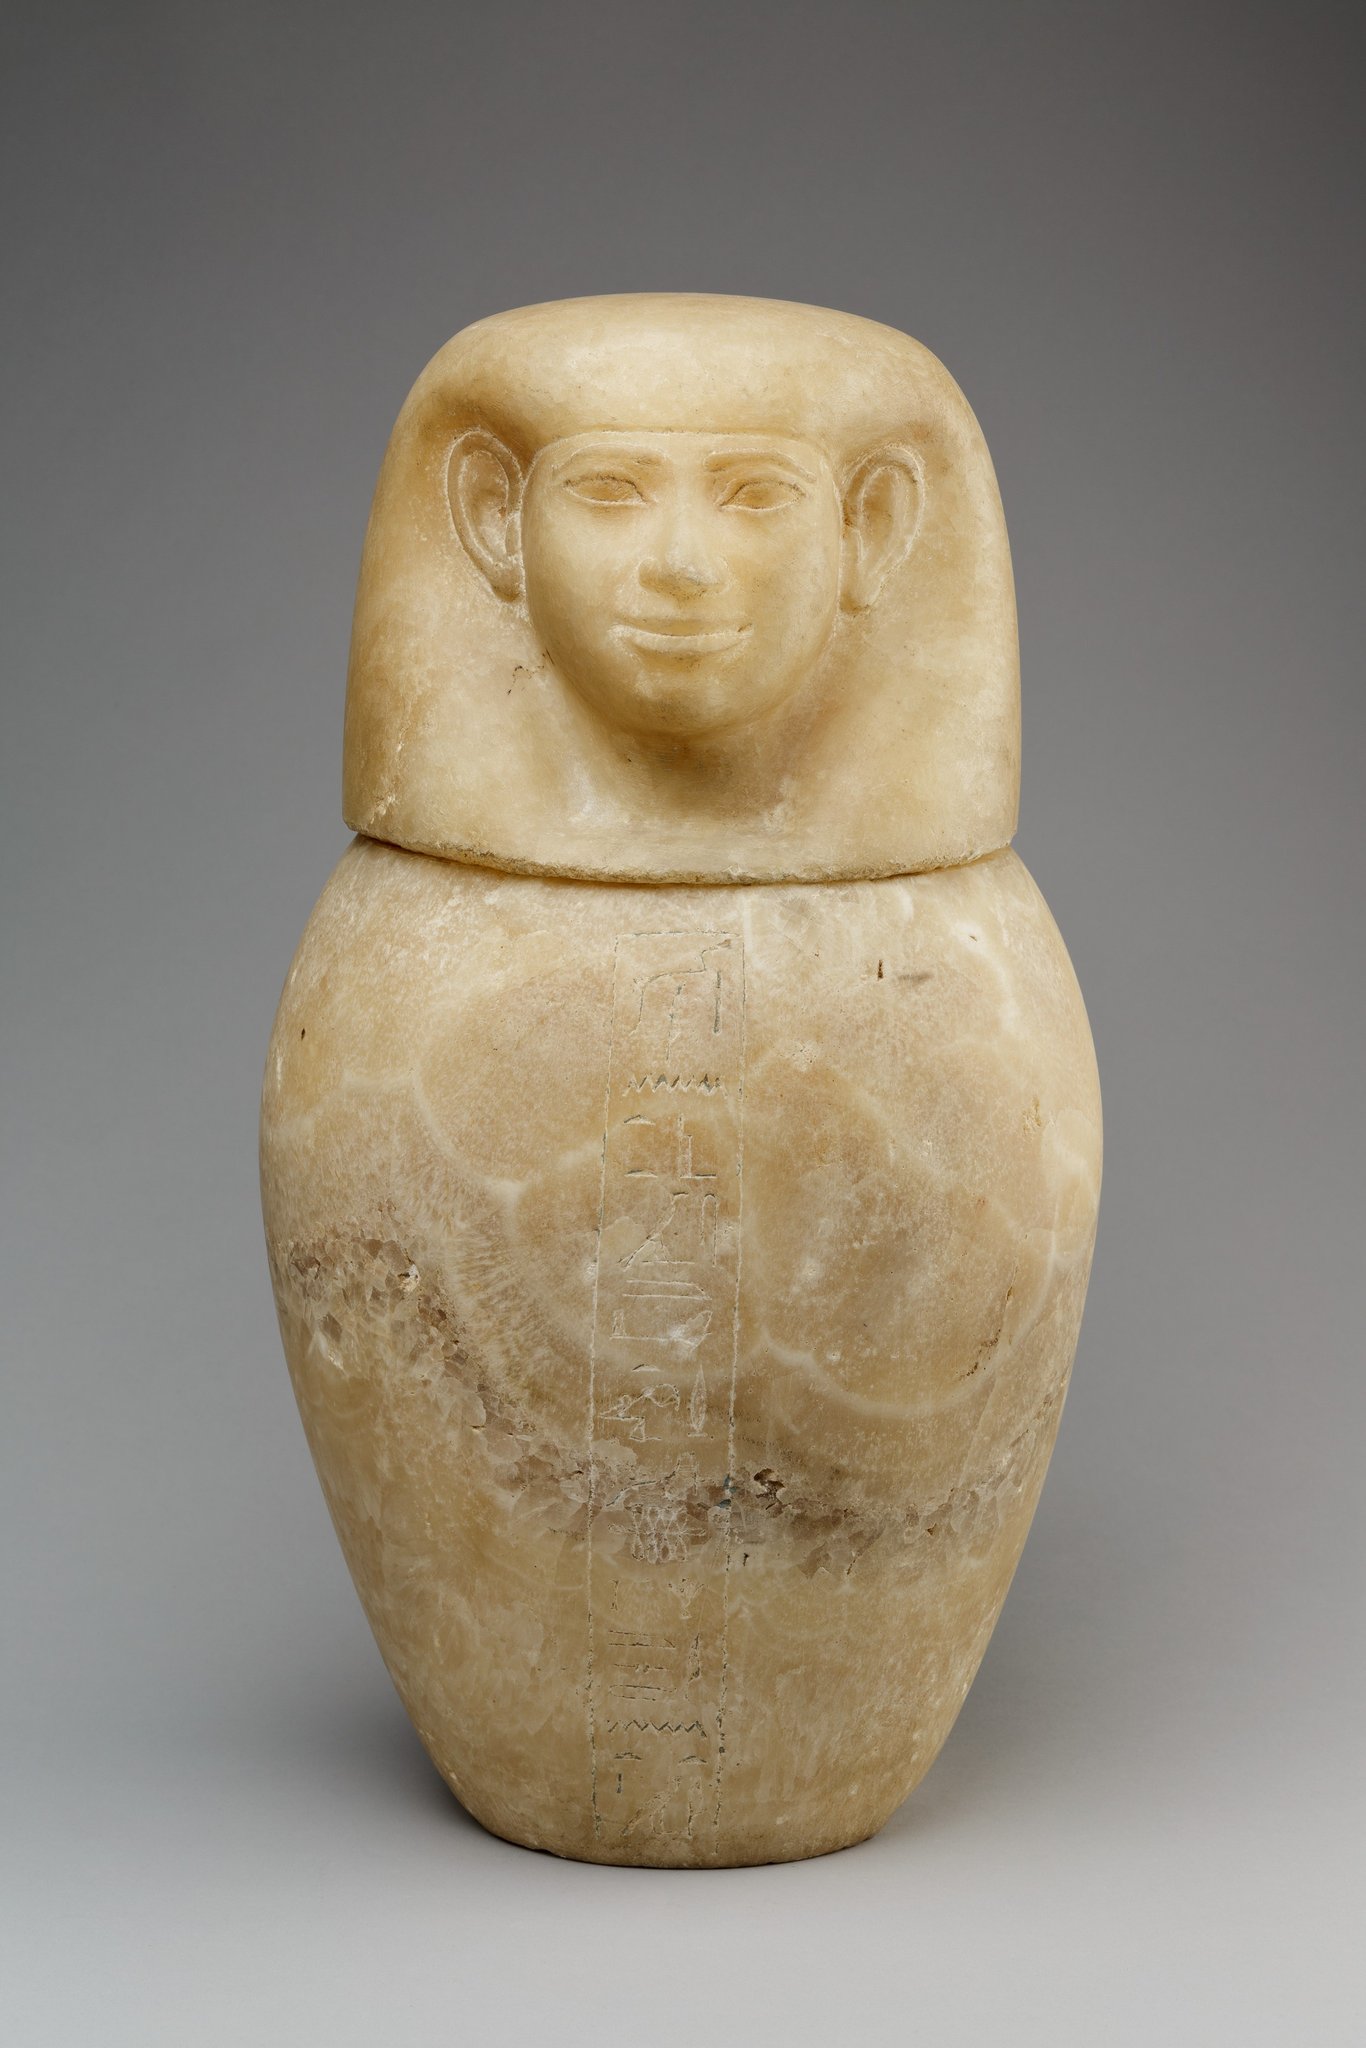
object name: canopic jar, human head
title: Canopic jar with a human-headed lid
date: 664-525 BCE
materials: stone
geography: upper egypt, thebes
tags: human figures,hieroglyphs